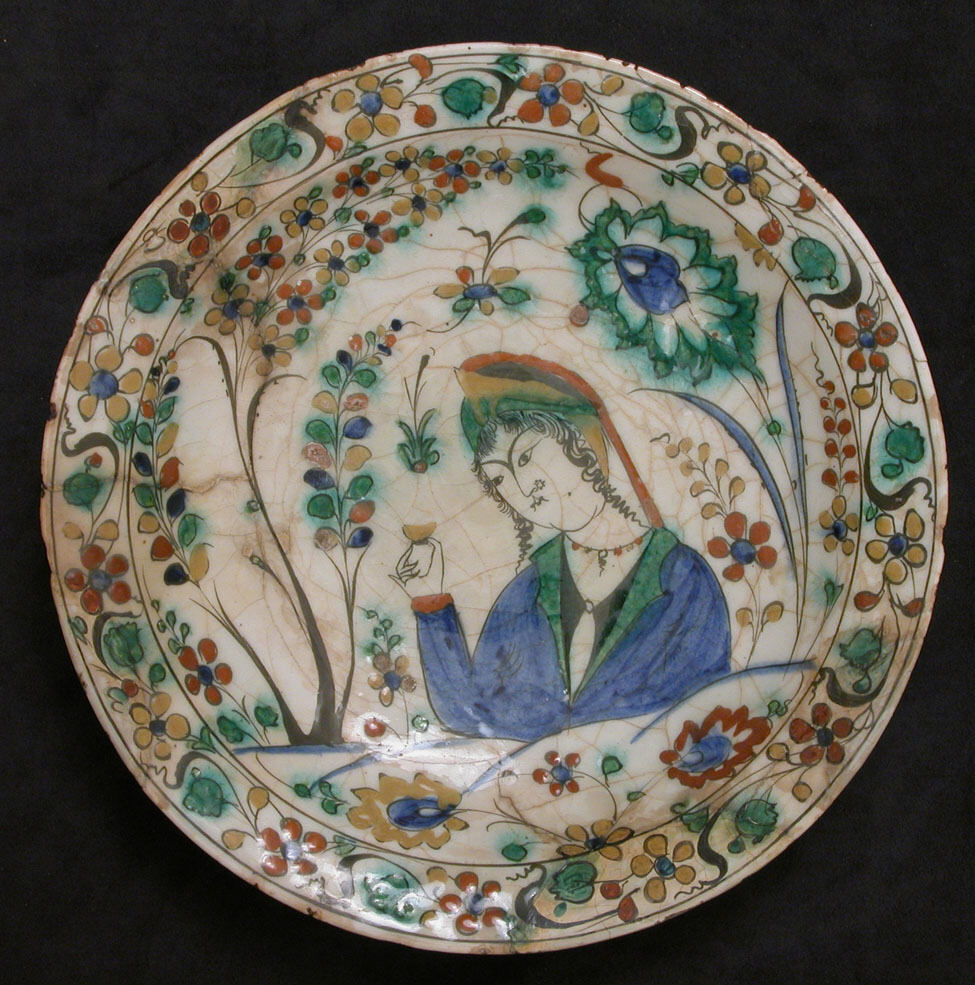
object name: dish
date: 1601-1633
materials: stonepaste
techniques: painting, underglaze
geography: northwestern iran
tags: women